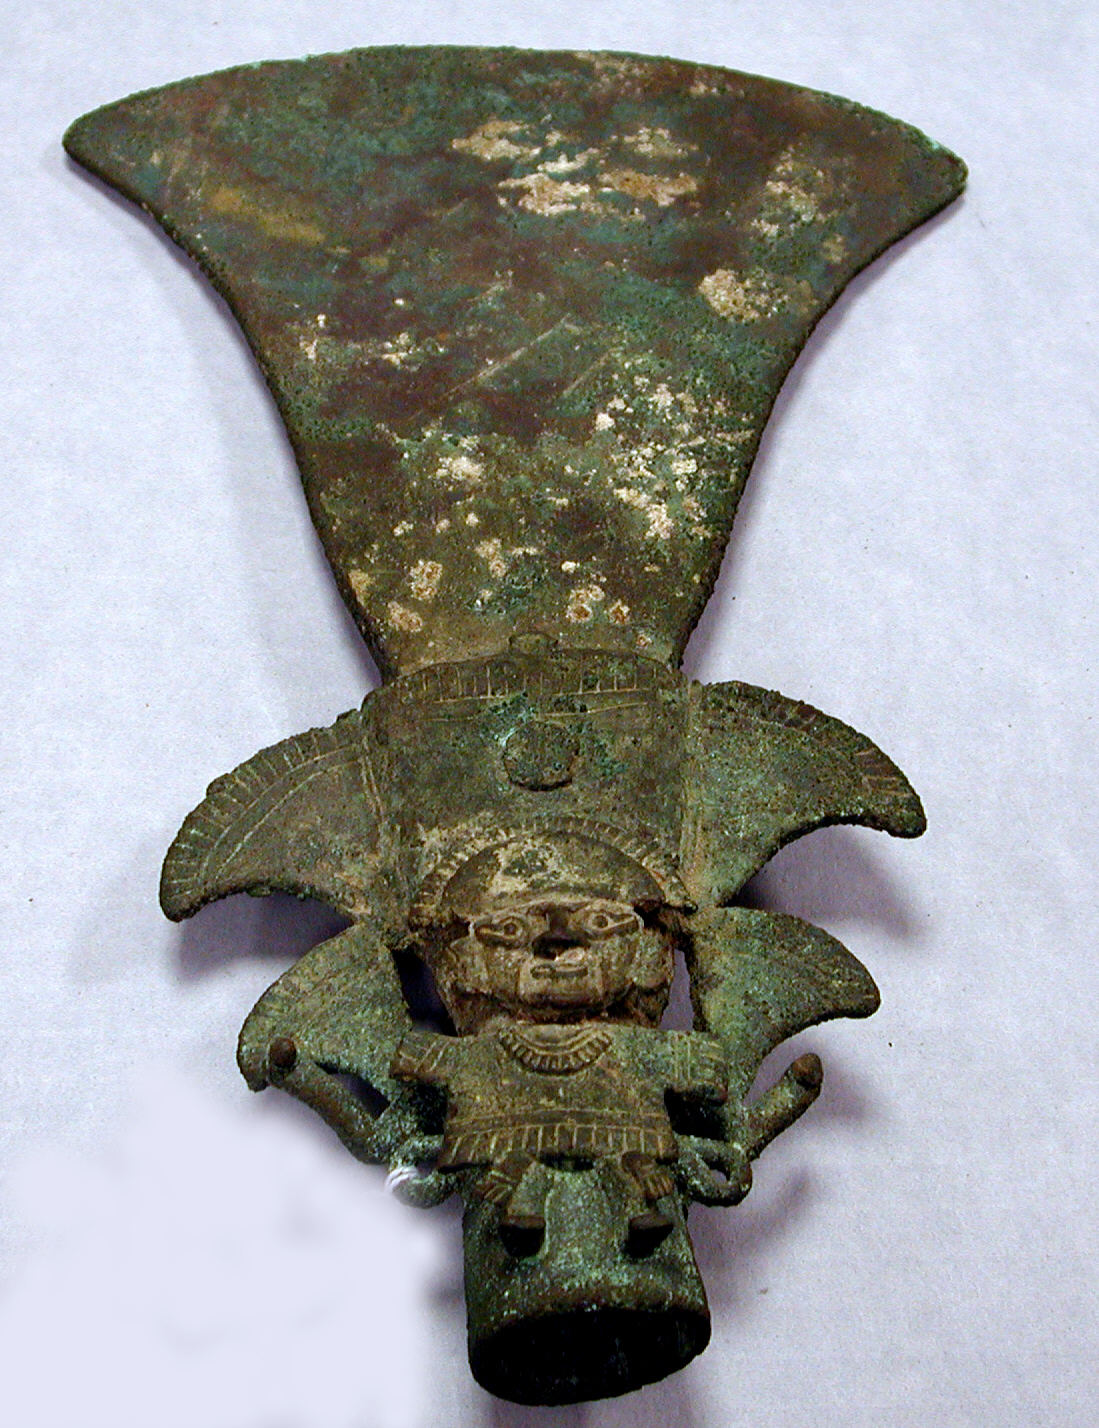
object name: finial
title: Copper Pole Top Ornament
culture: chimú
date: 1101-1500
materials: copper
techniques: casting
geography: peru